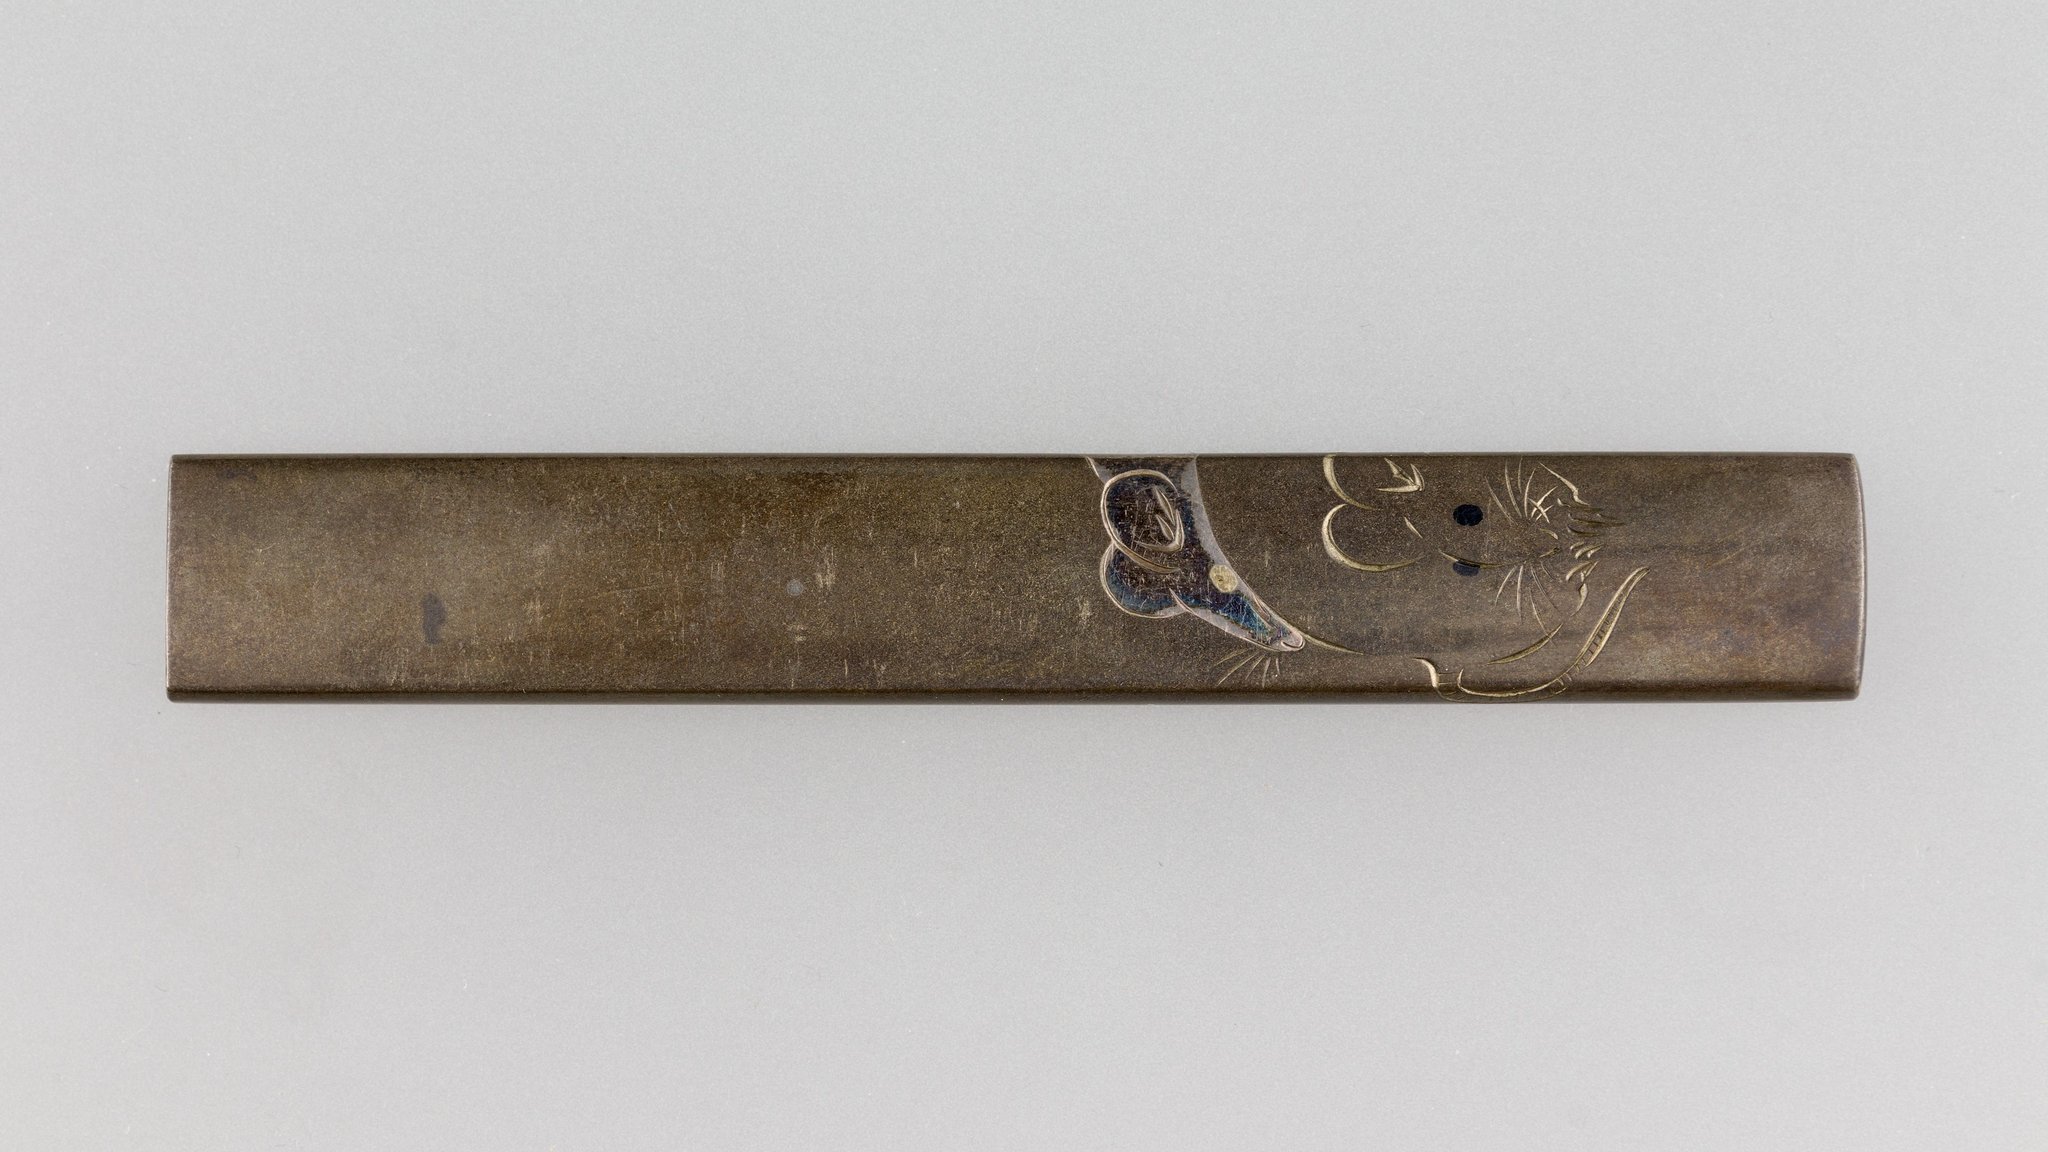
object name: knife handle kozuka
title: Knife Handle (Kozuka)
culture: japanese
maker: kanō natsuo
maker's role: fittings maker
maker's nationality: japanese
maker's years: 1828-1898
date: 1834-1866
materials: gold alloy, silver alloy, silver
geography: japan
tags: mice